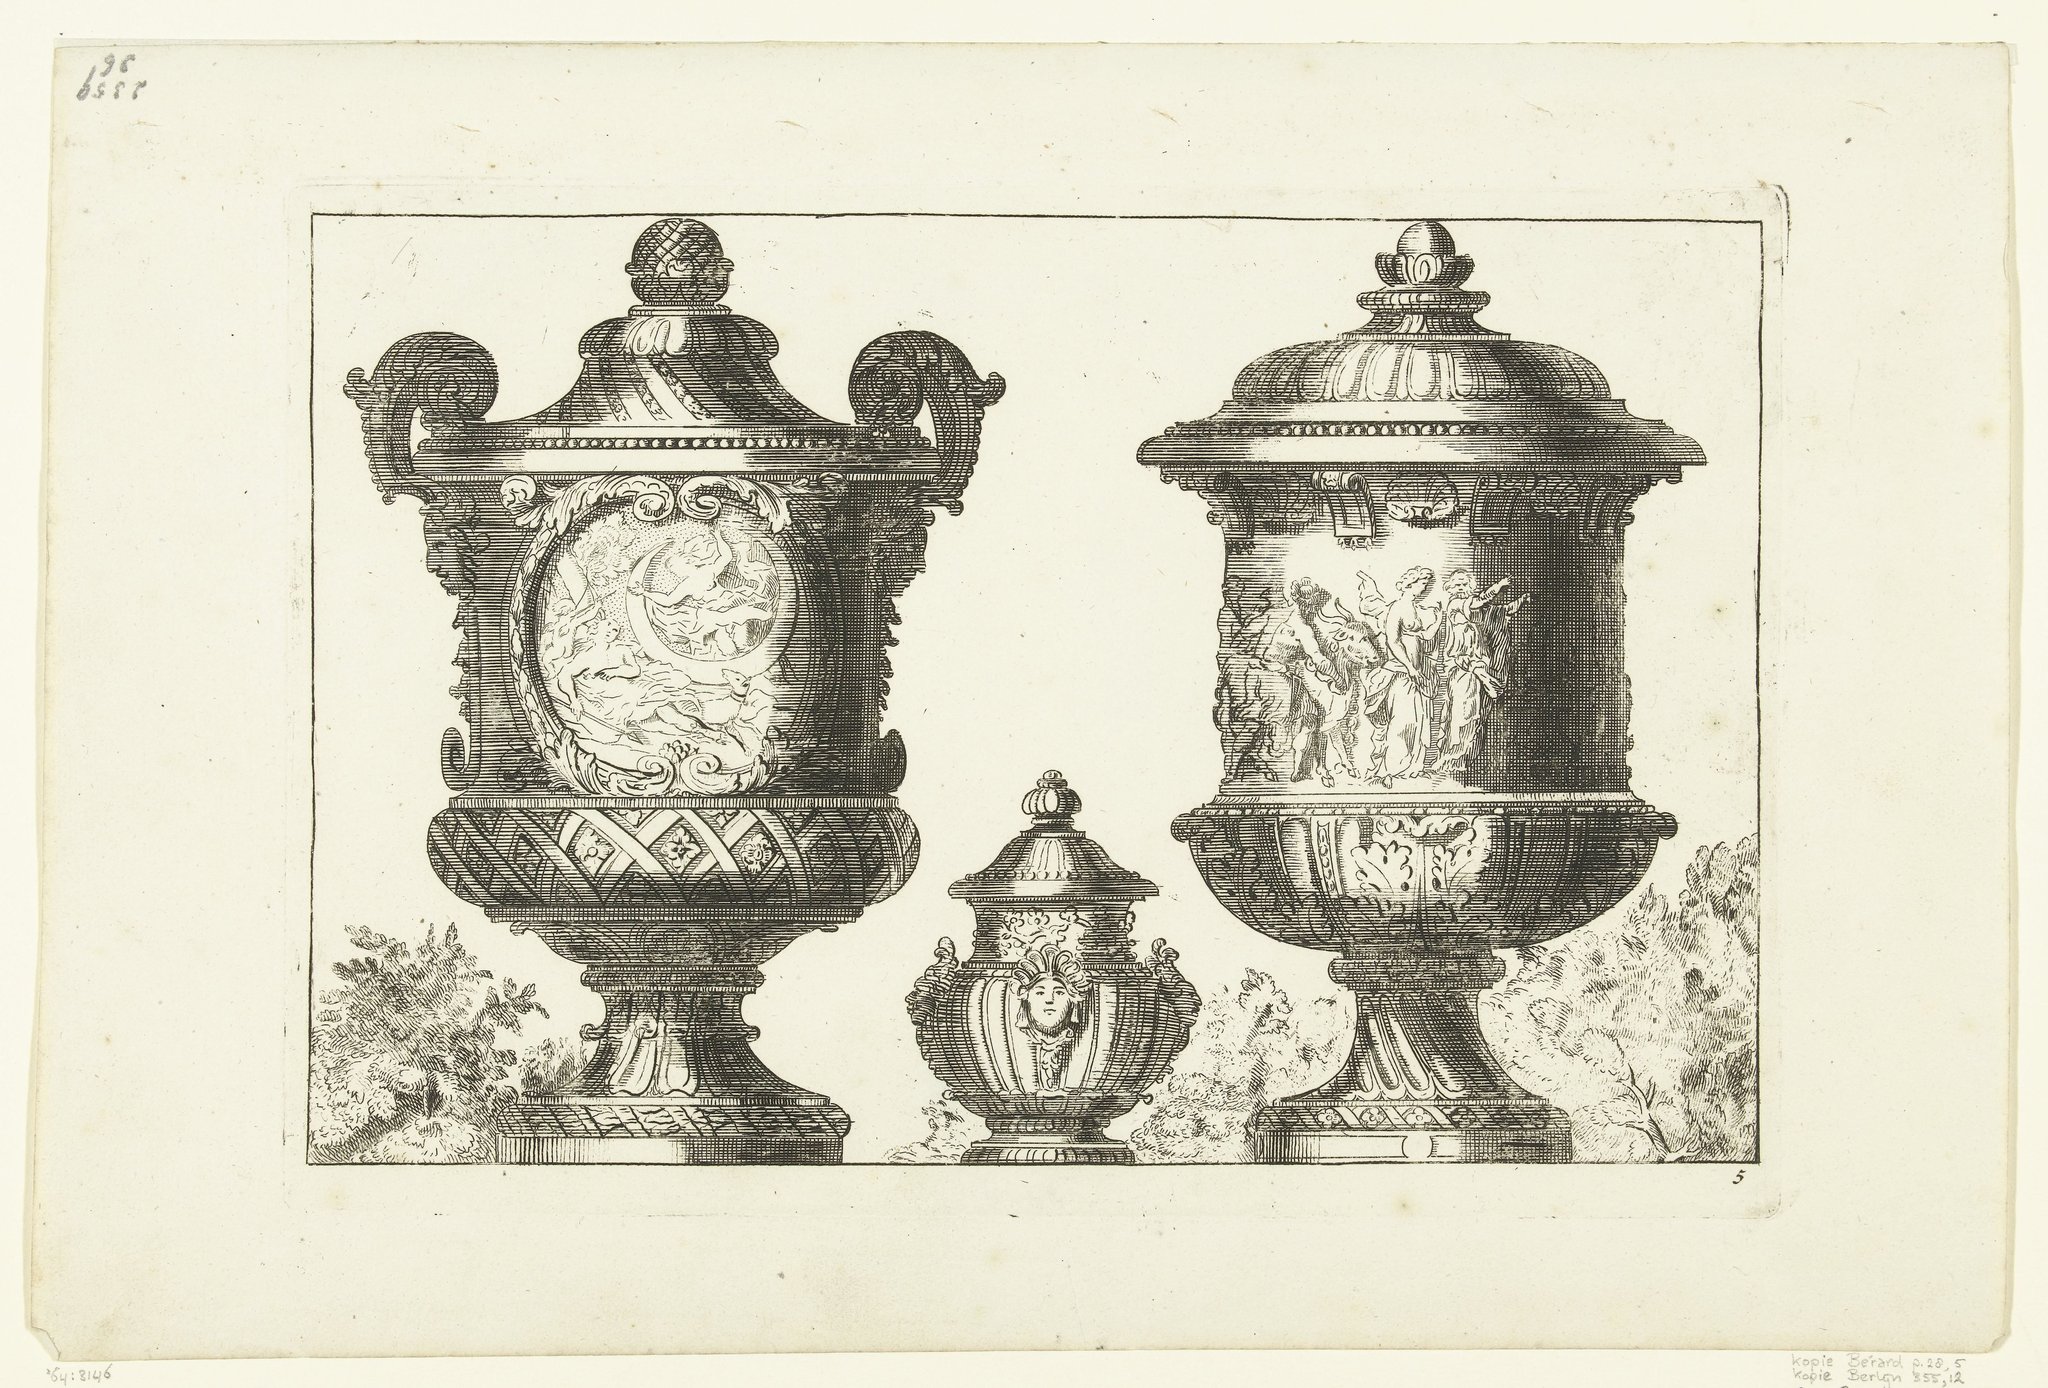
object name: print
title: Twee grote urnen en een kleine urn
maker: Anonymous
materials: paper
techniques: etching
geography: netherlands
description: De urnen hebben deksels. De linker urn is gedecoreerd met een medaillon met Diana en Endymion, de rechter met een offerscène. Kopie naar blad uit serie Nouveaux Liure de Vases et de Pots de Jardins uitgegeven door Daniel Marot.